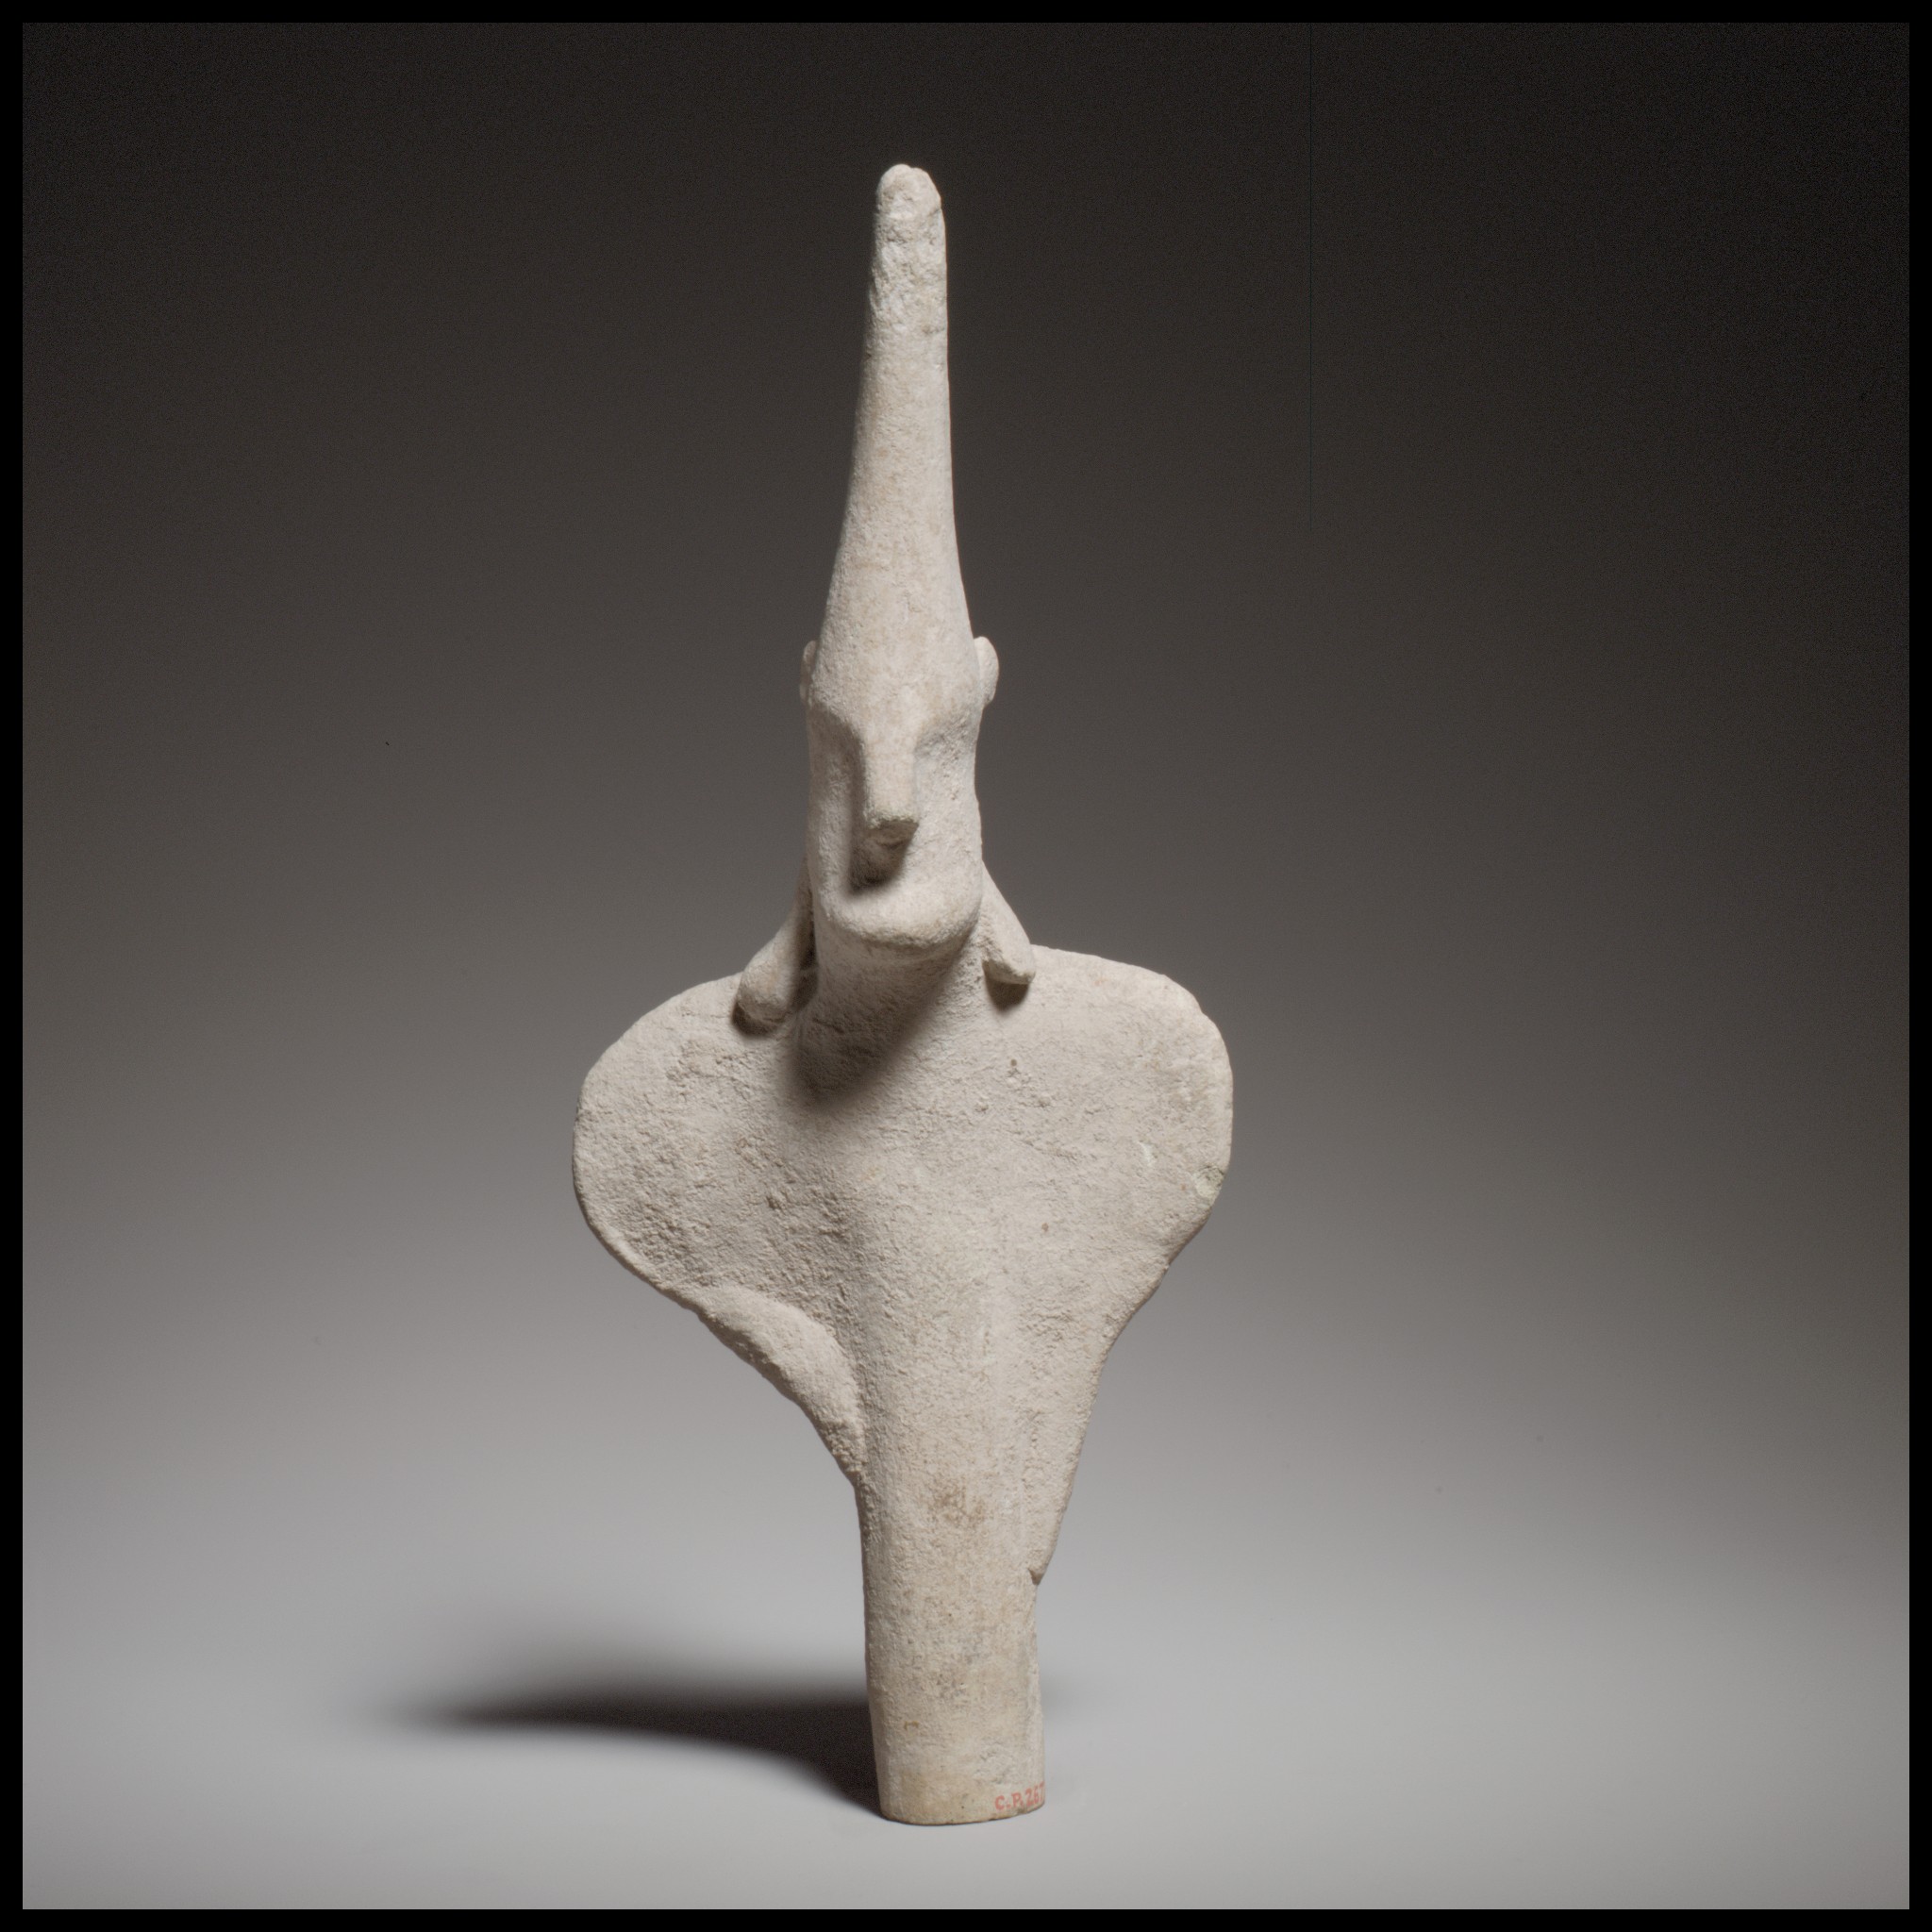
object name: statuette of a votary, male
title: Standing male figurine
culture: cypriot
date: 600-480 BCE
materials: terracotta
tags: men